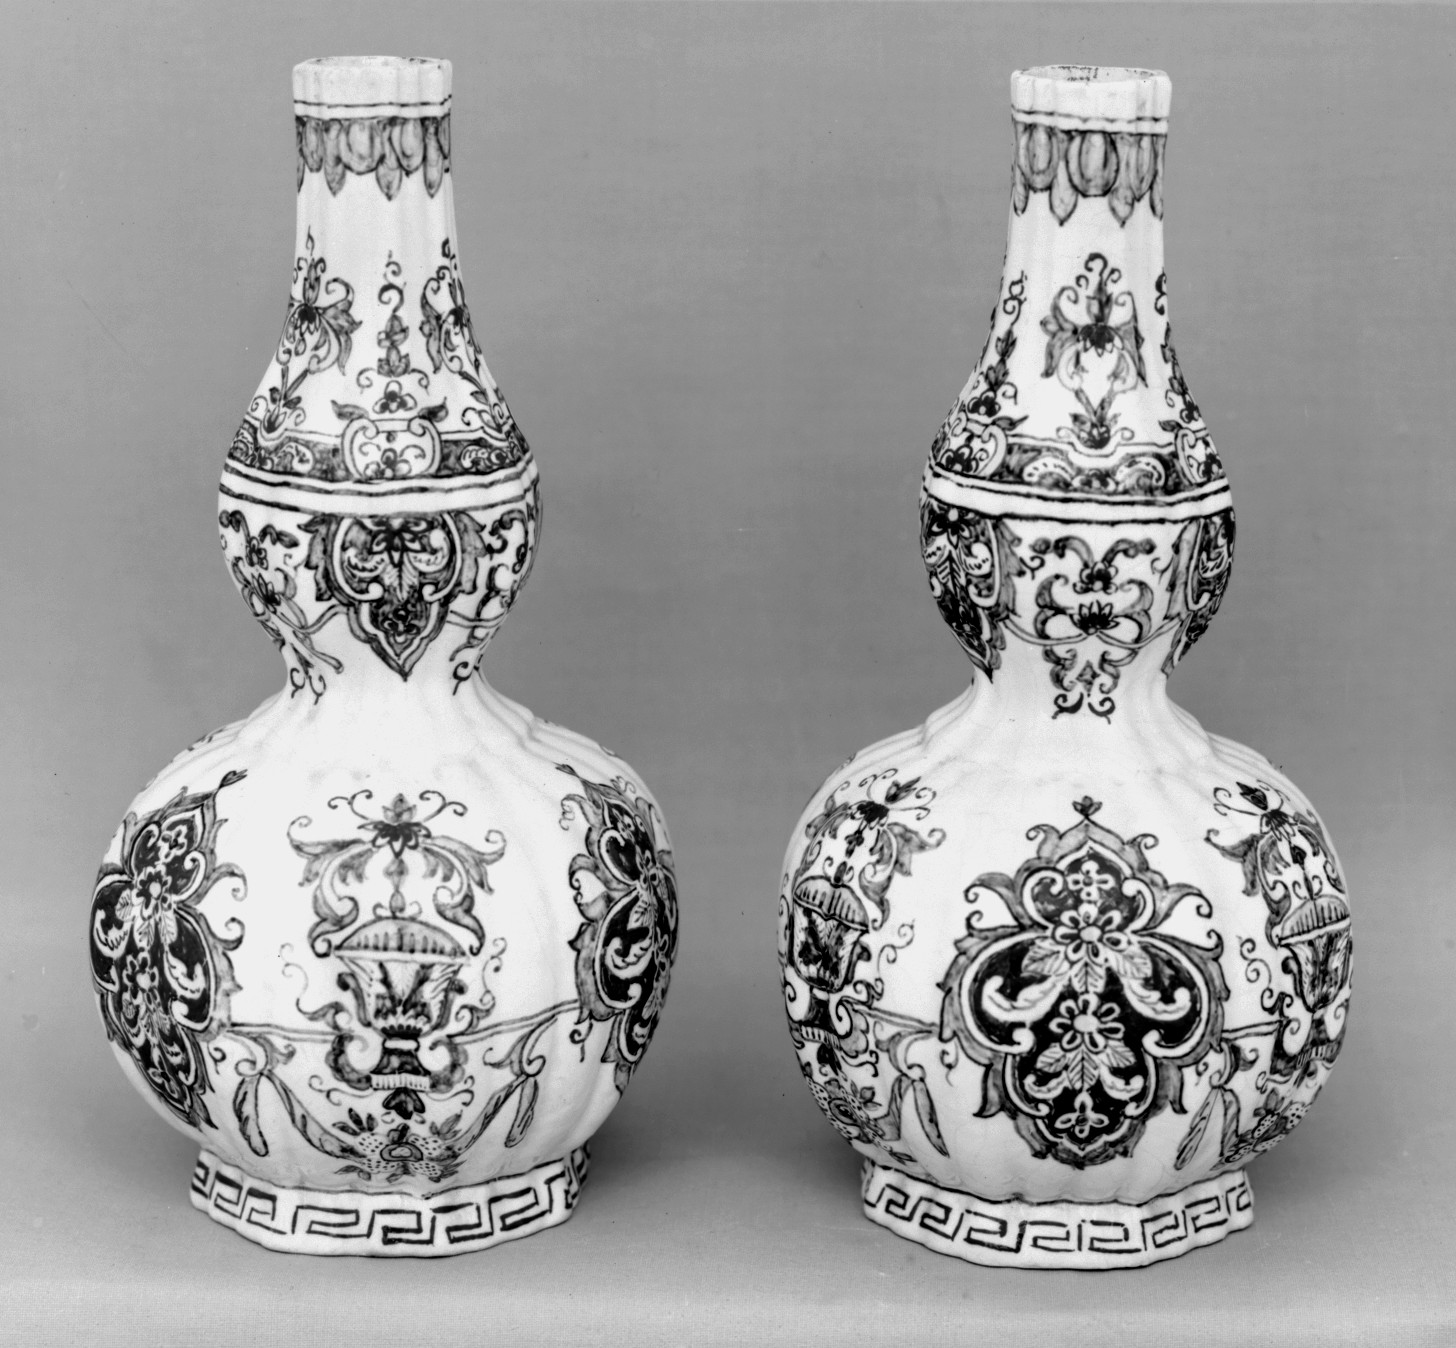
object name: bottle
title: Pair of bottles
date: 1801-1900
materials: earthenware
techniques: glazing